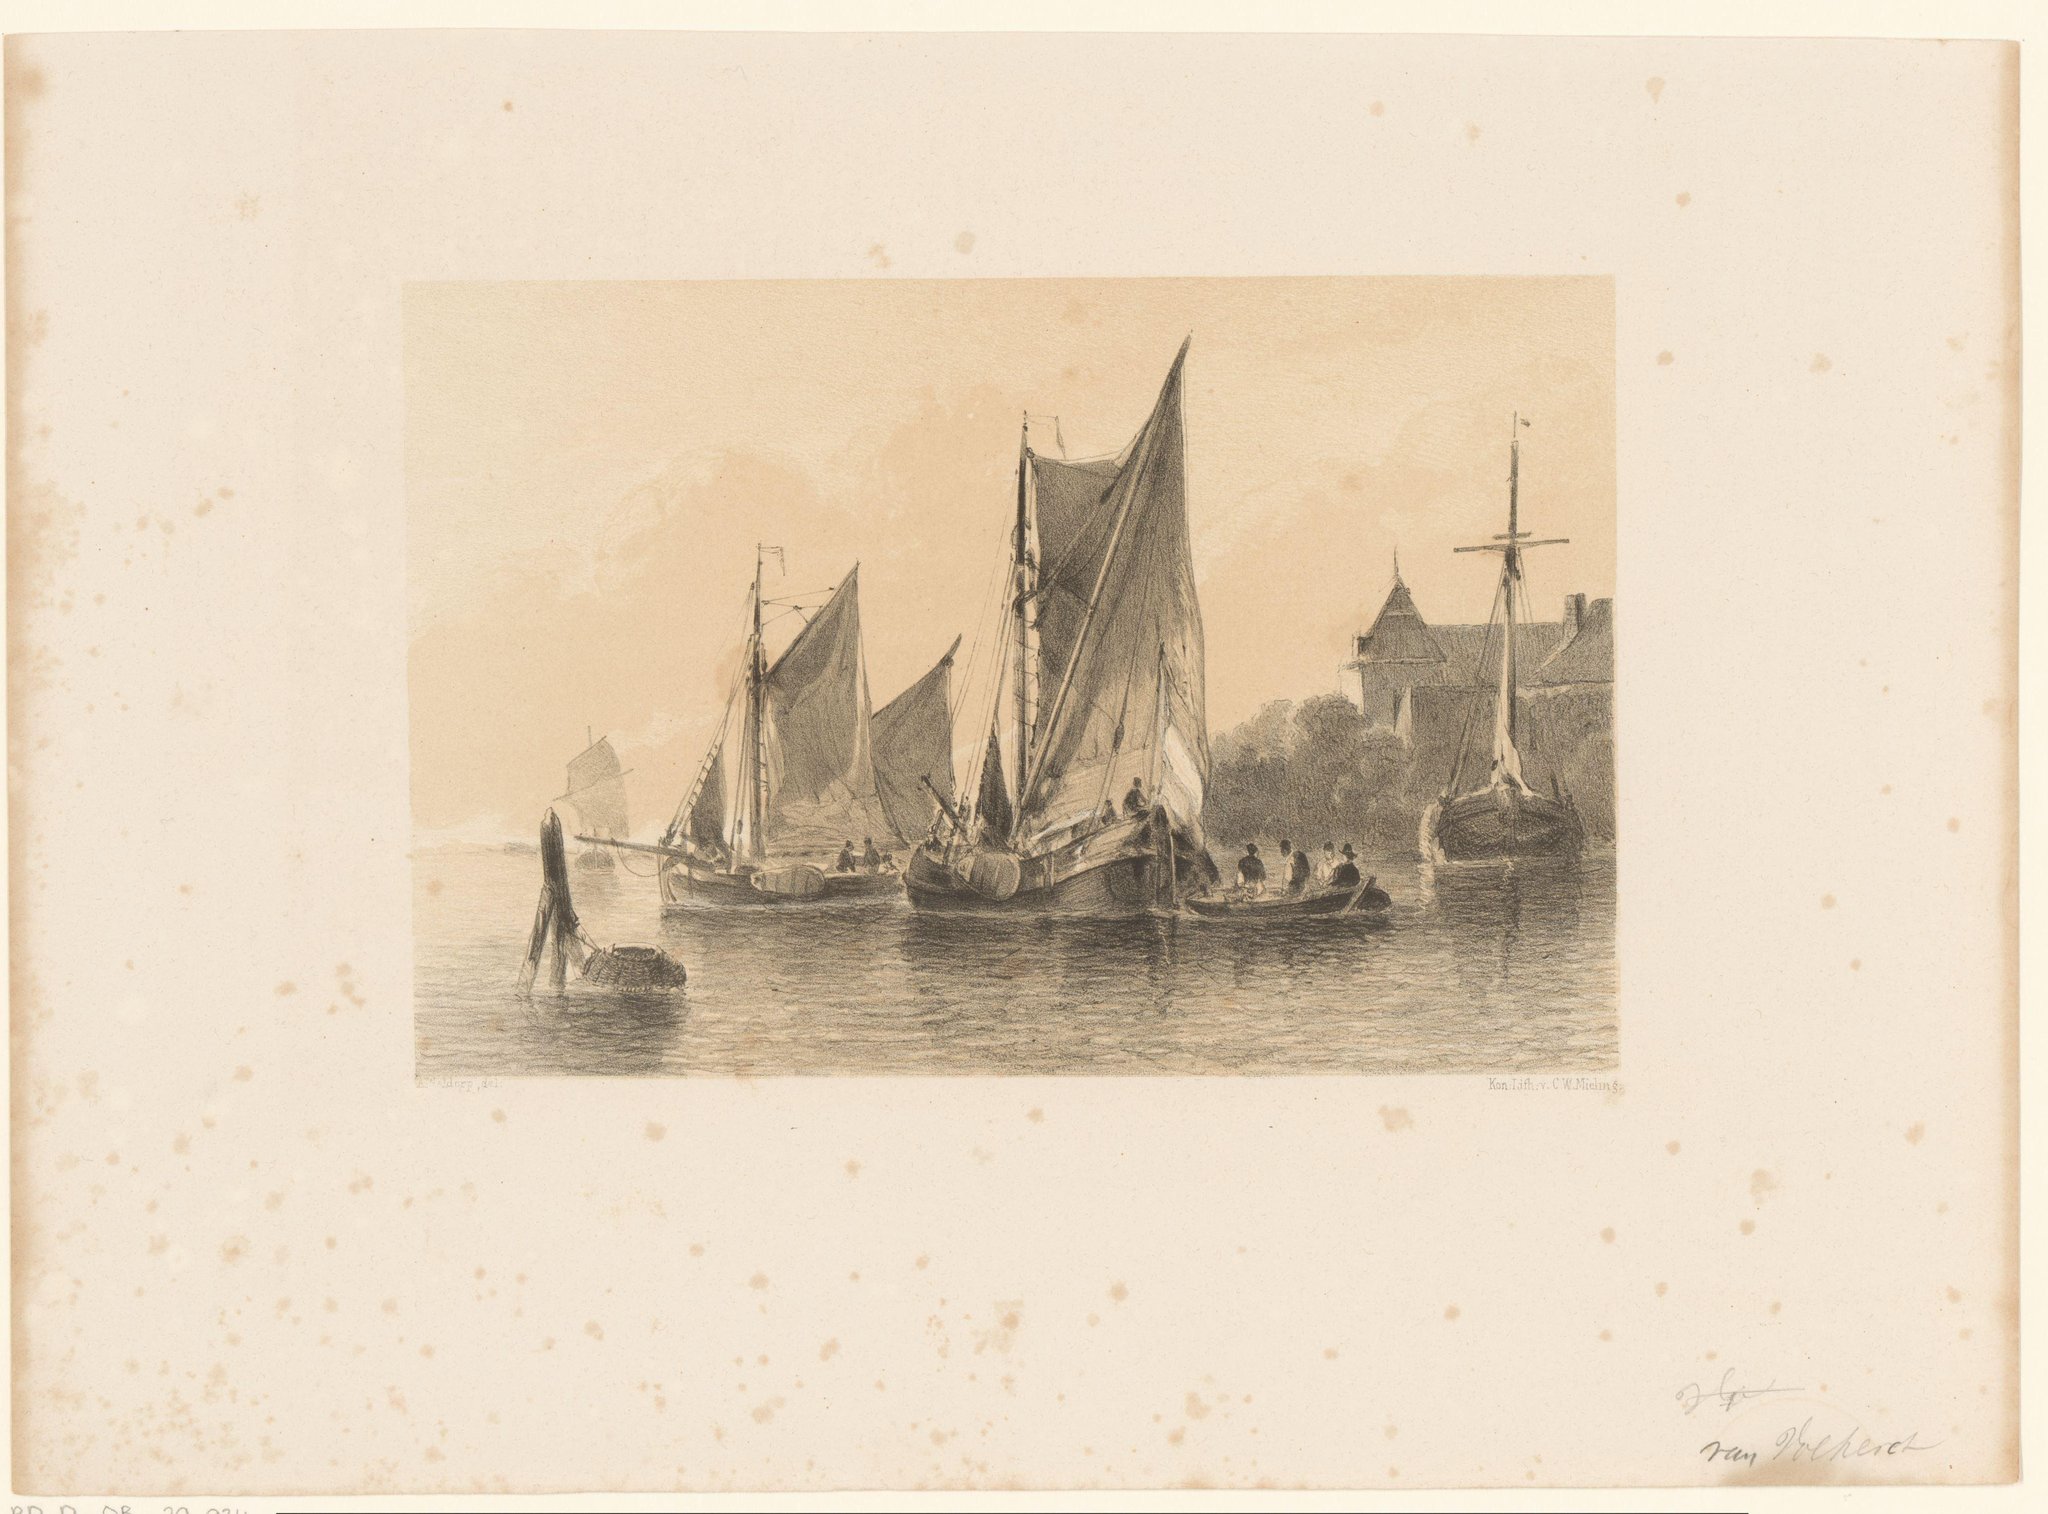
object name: print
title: Zeilboten op rivier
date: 1847-1865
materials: paper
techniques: tone lithography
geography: the hague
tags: sailing-ship, sailing-boat, river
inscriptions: collector's mark: Lugt 2228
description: Zeilboten en een roeiboot varend op een rivier.